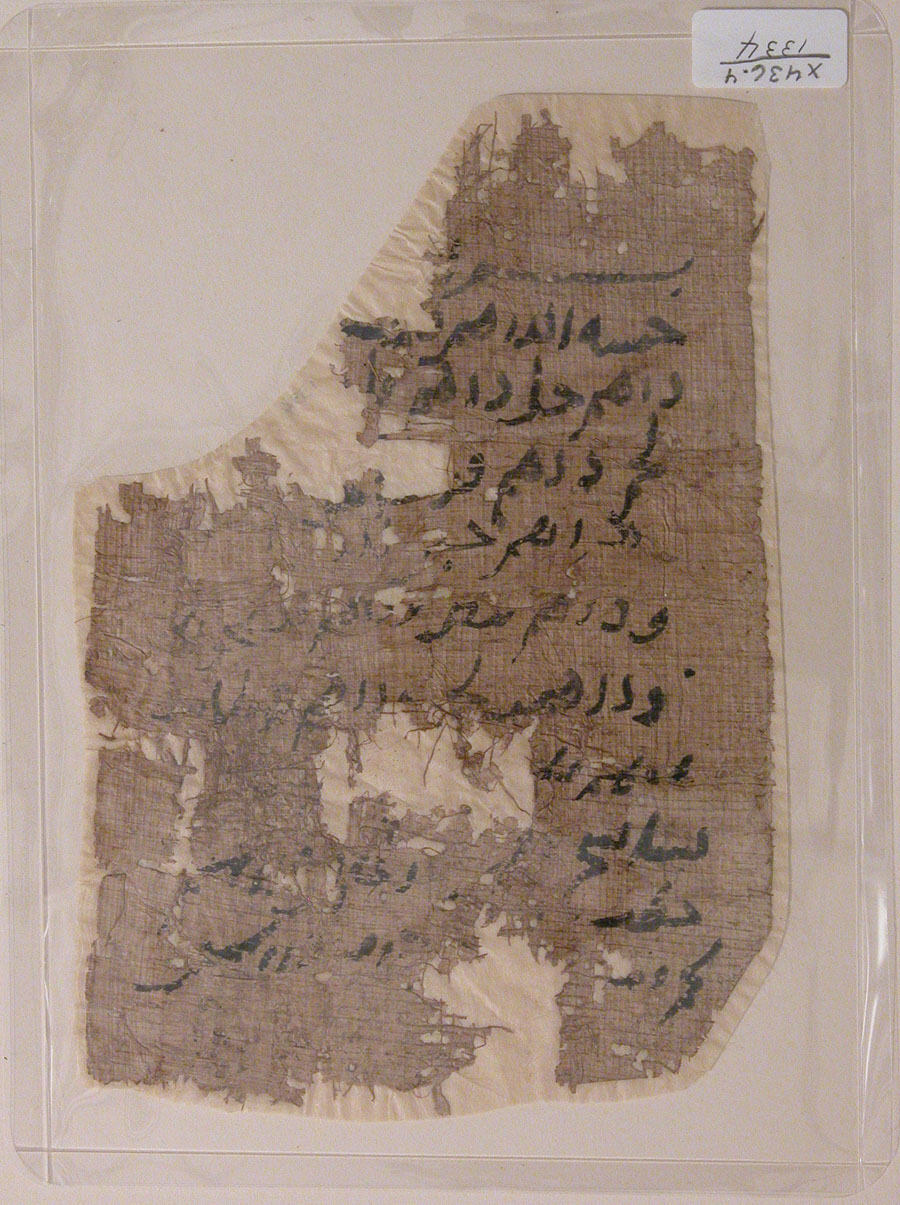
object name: fragment of a non illustrated single work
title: Papyrus Fragment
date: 701-1000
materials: ink, papyrus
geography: egypt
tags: arabic,documents